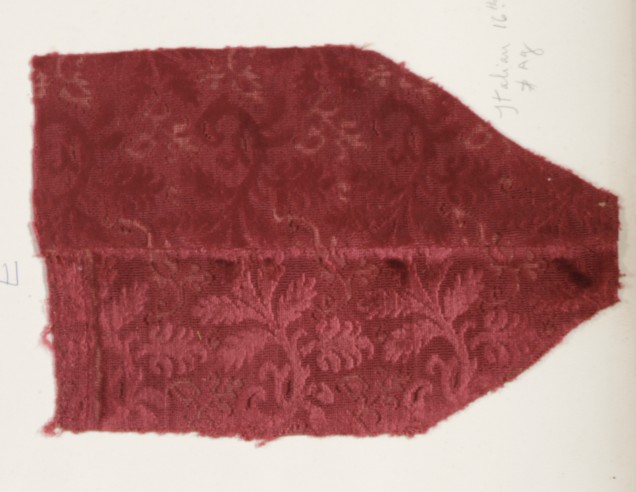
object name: fragment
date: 1501-1600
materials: silk